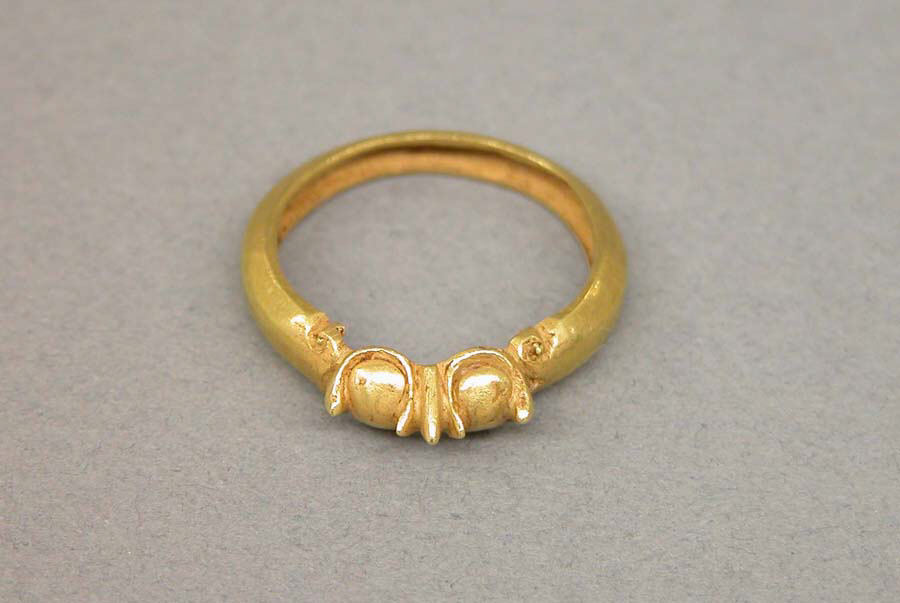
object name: ring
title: Ring with Double Vegetal Motifs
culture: indonesian, javanese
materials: gold